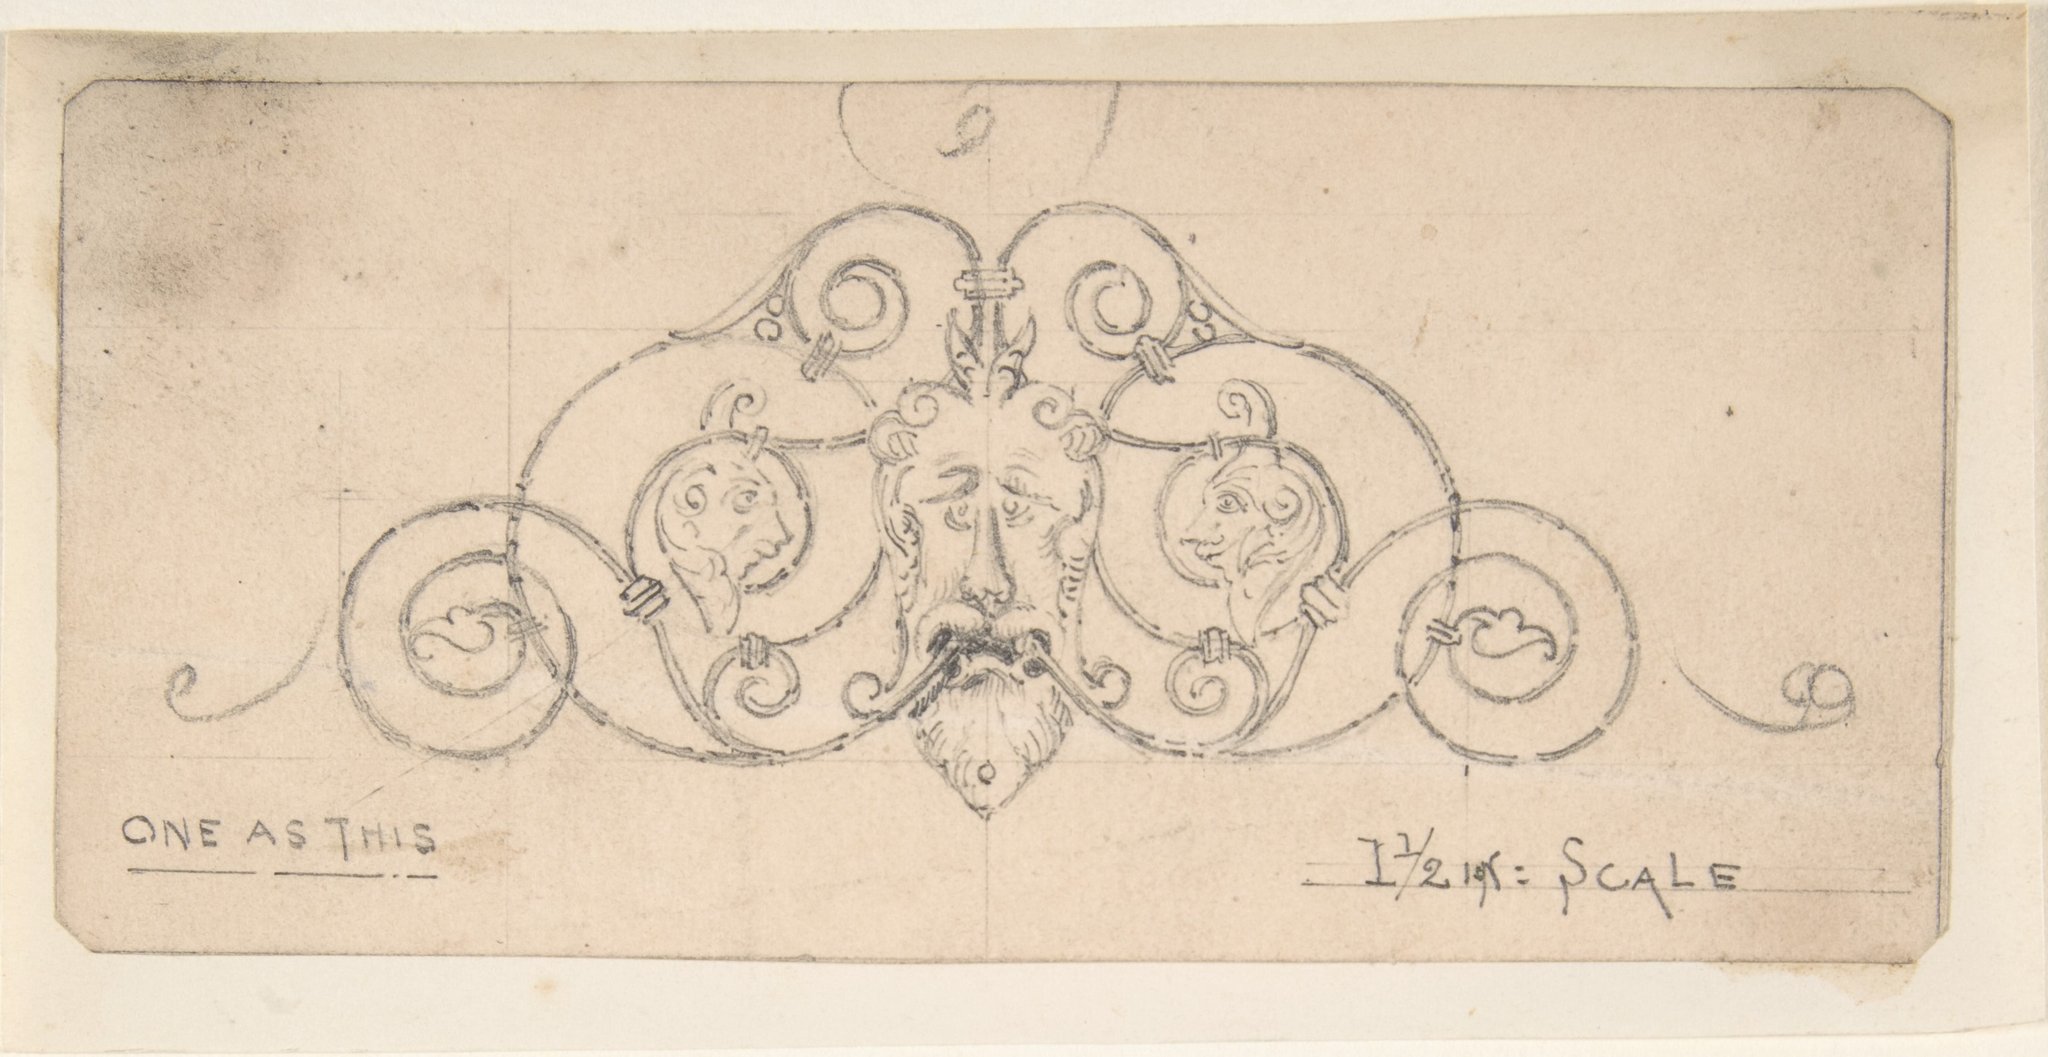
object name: drawing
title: Wrought Metal Foliate Ornament with Grotesque Masks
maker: anonymous, british, 19th century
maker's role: artist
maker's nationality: british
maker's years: 1800-1900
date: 1870-1890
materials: graphite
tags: grotesques,ornament